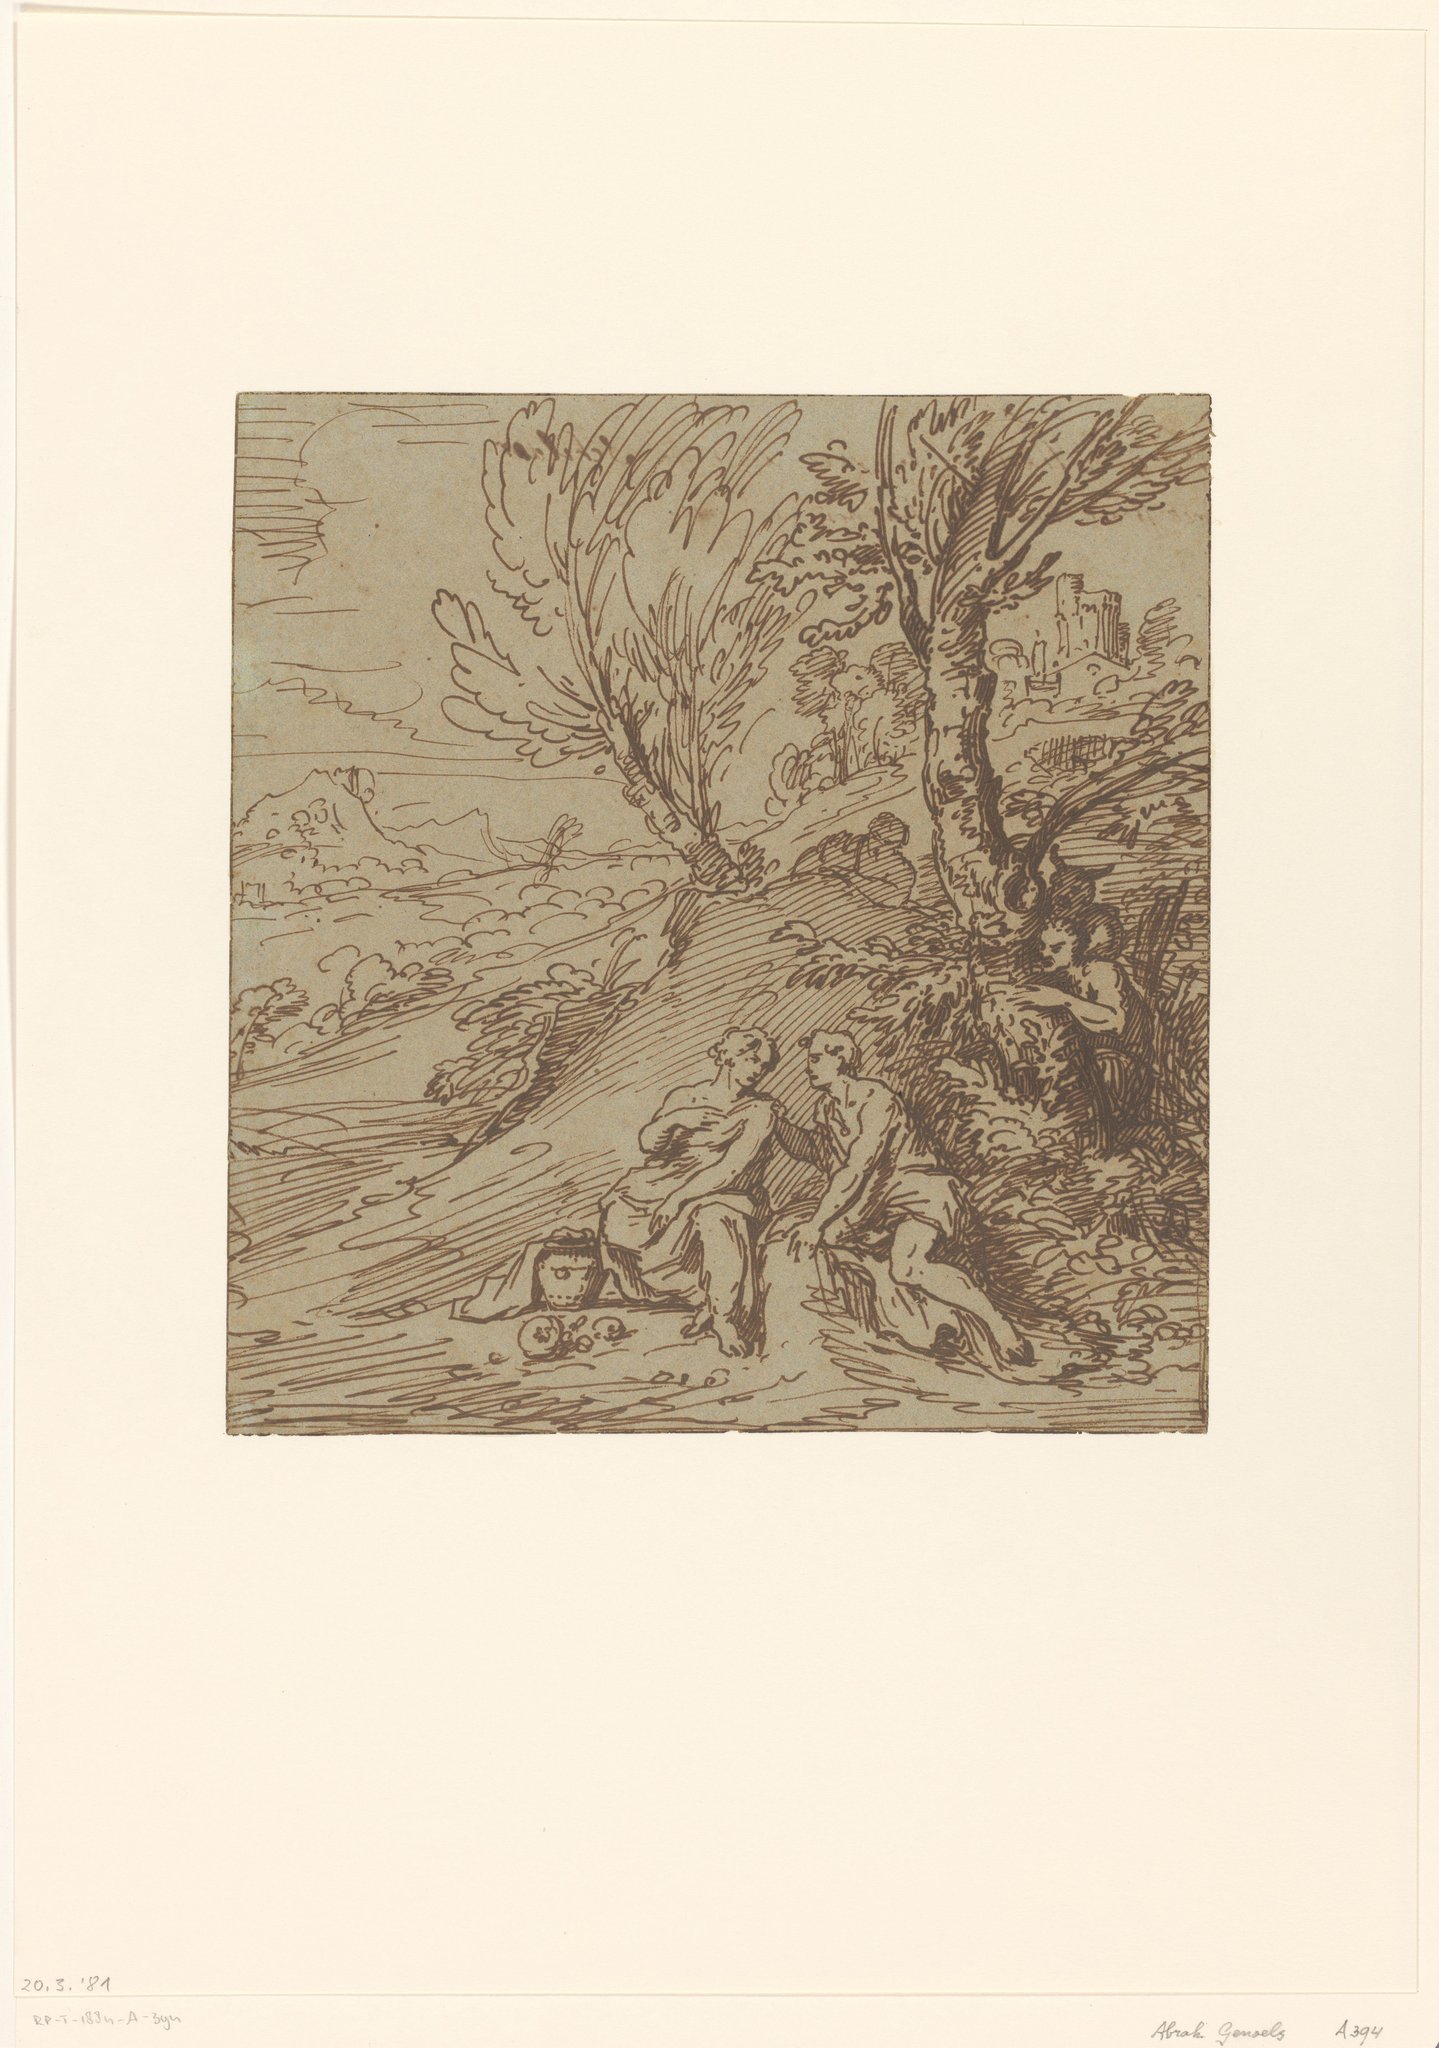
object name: drawing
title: Landschap met liefdespaar bespiedt door saters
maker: abraham genoels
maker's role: draughtsman, print maker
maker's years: 1640-1723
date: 1650-1723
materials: ink, paper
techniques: pen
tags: satyr(s) (in general), lovers spied upon, pastorals, arcadian scenes